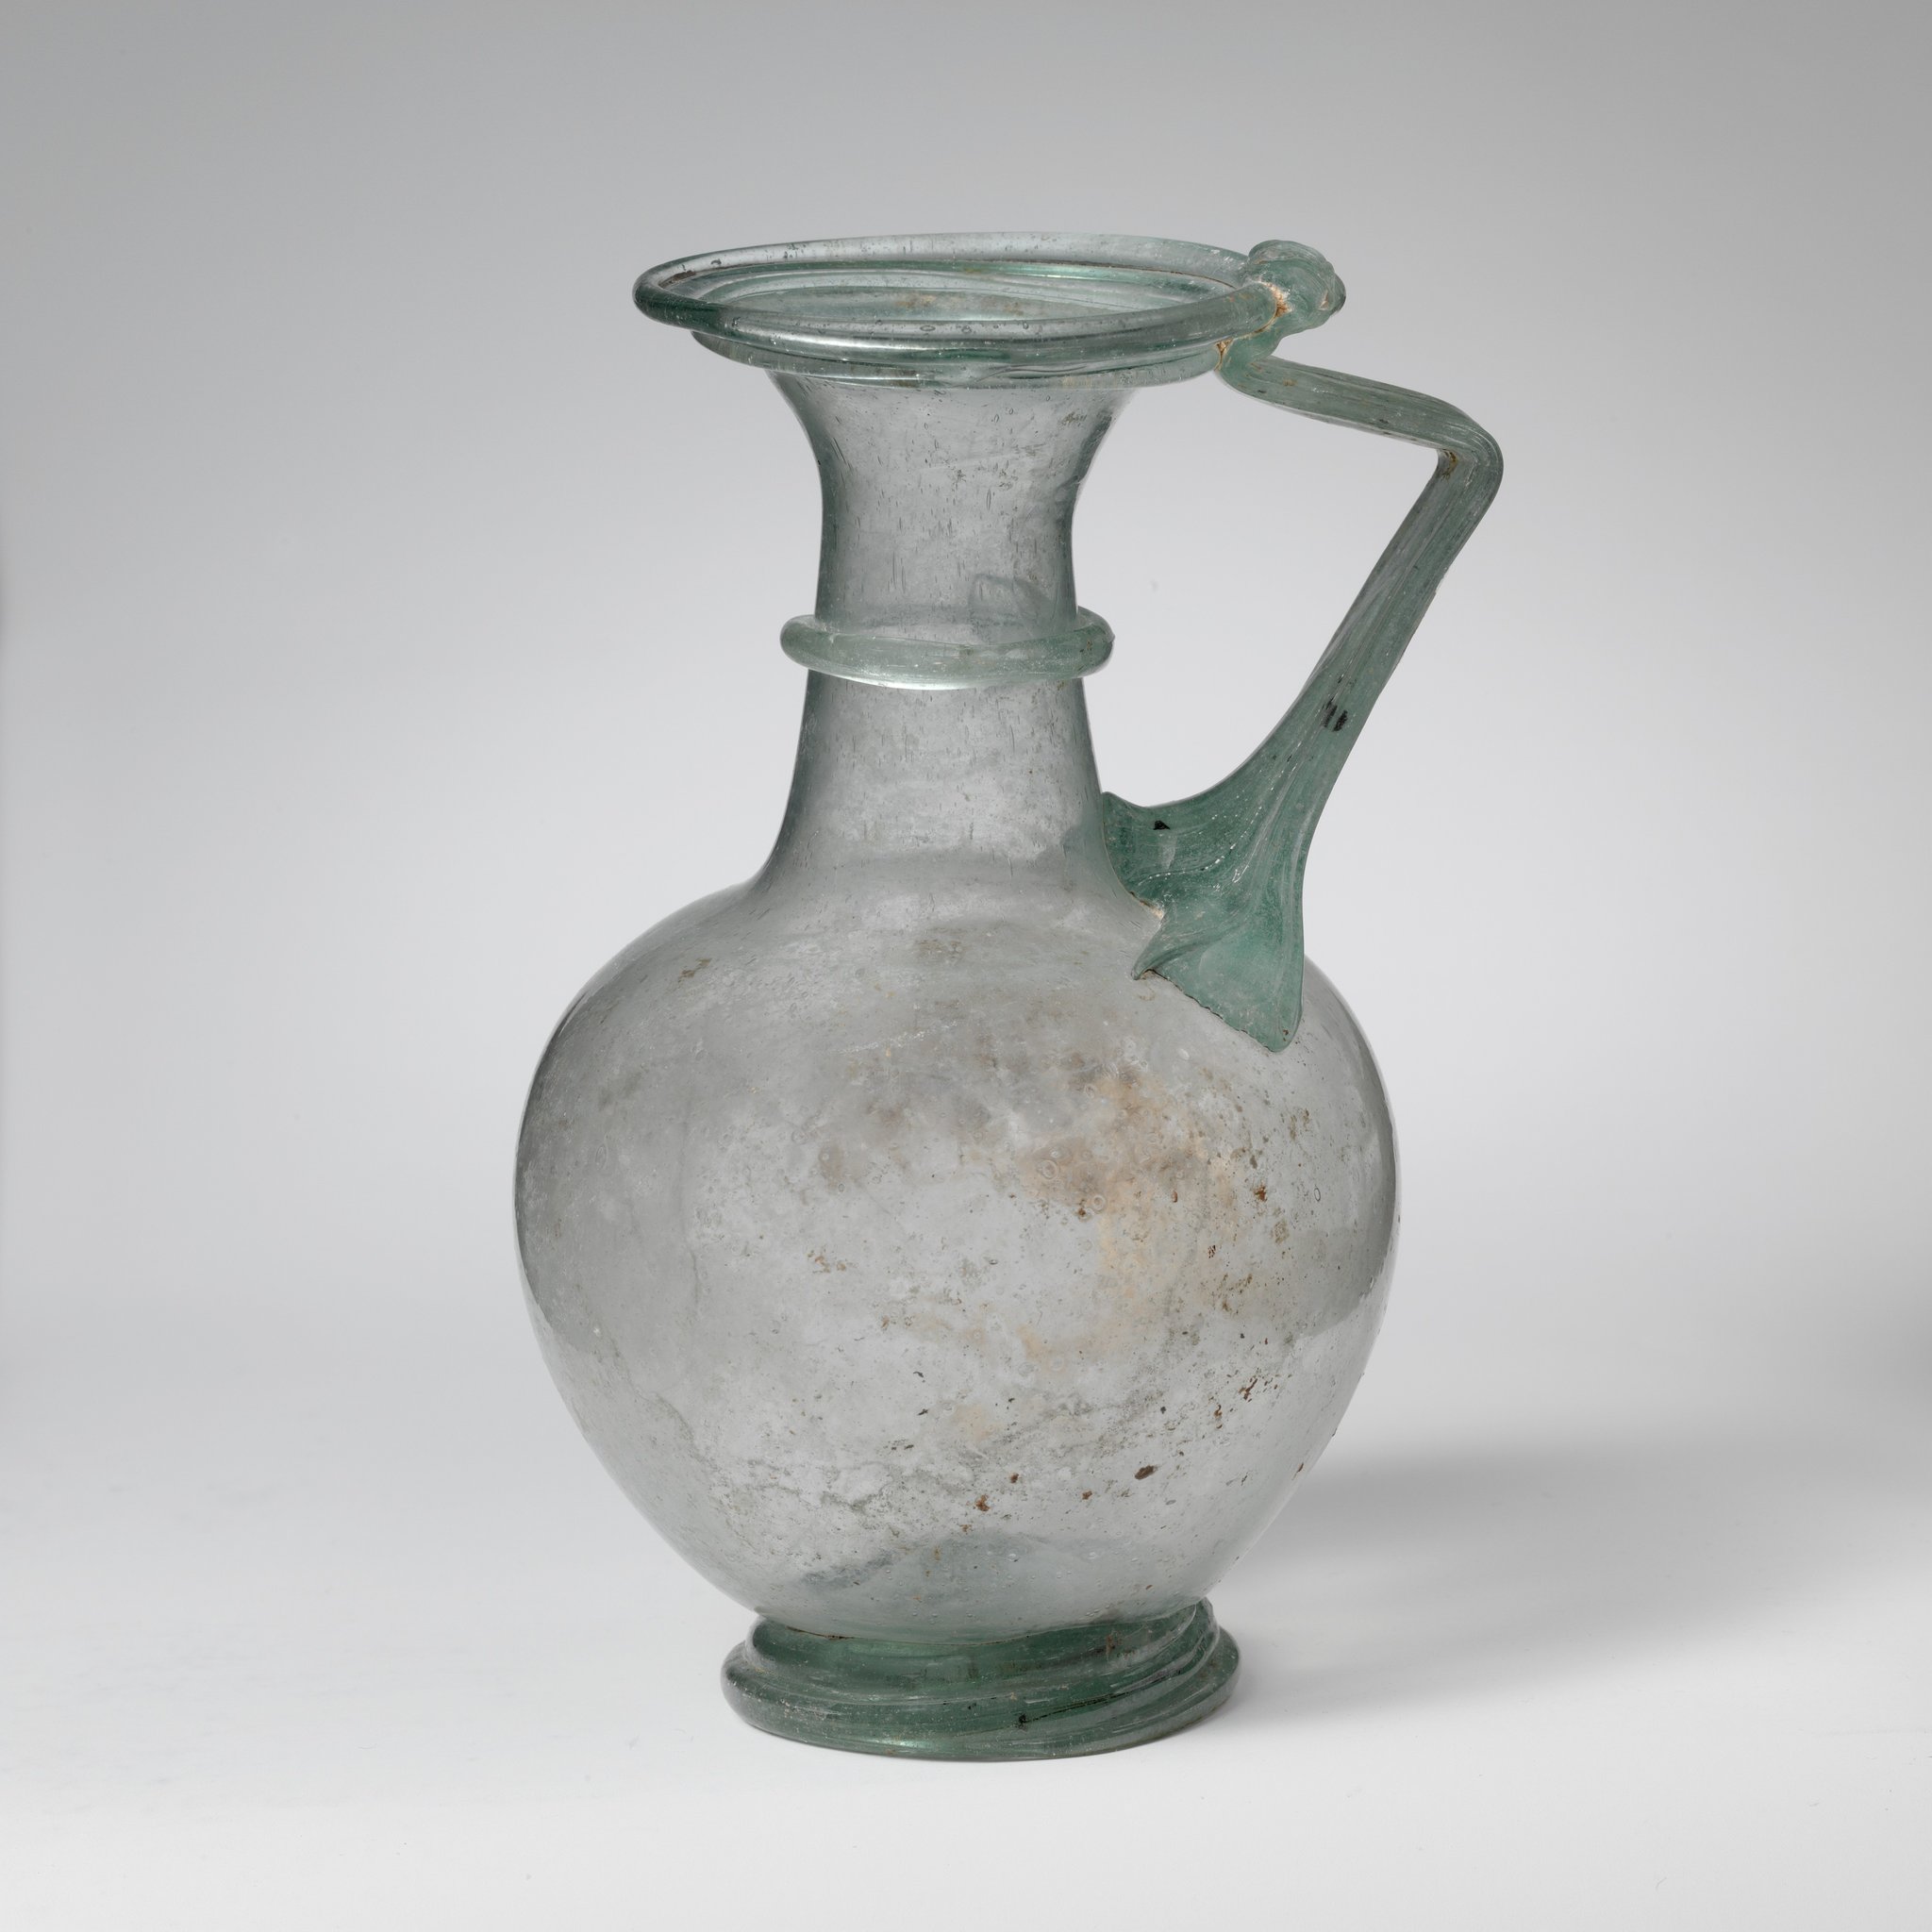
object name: jug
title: Glass jug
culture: roman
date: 201-400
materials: glass